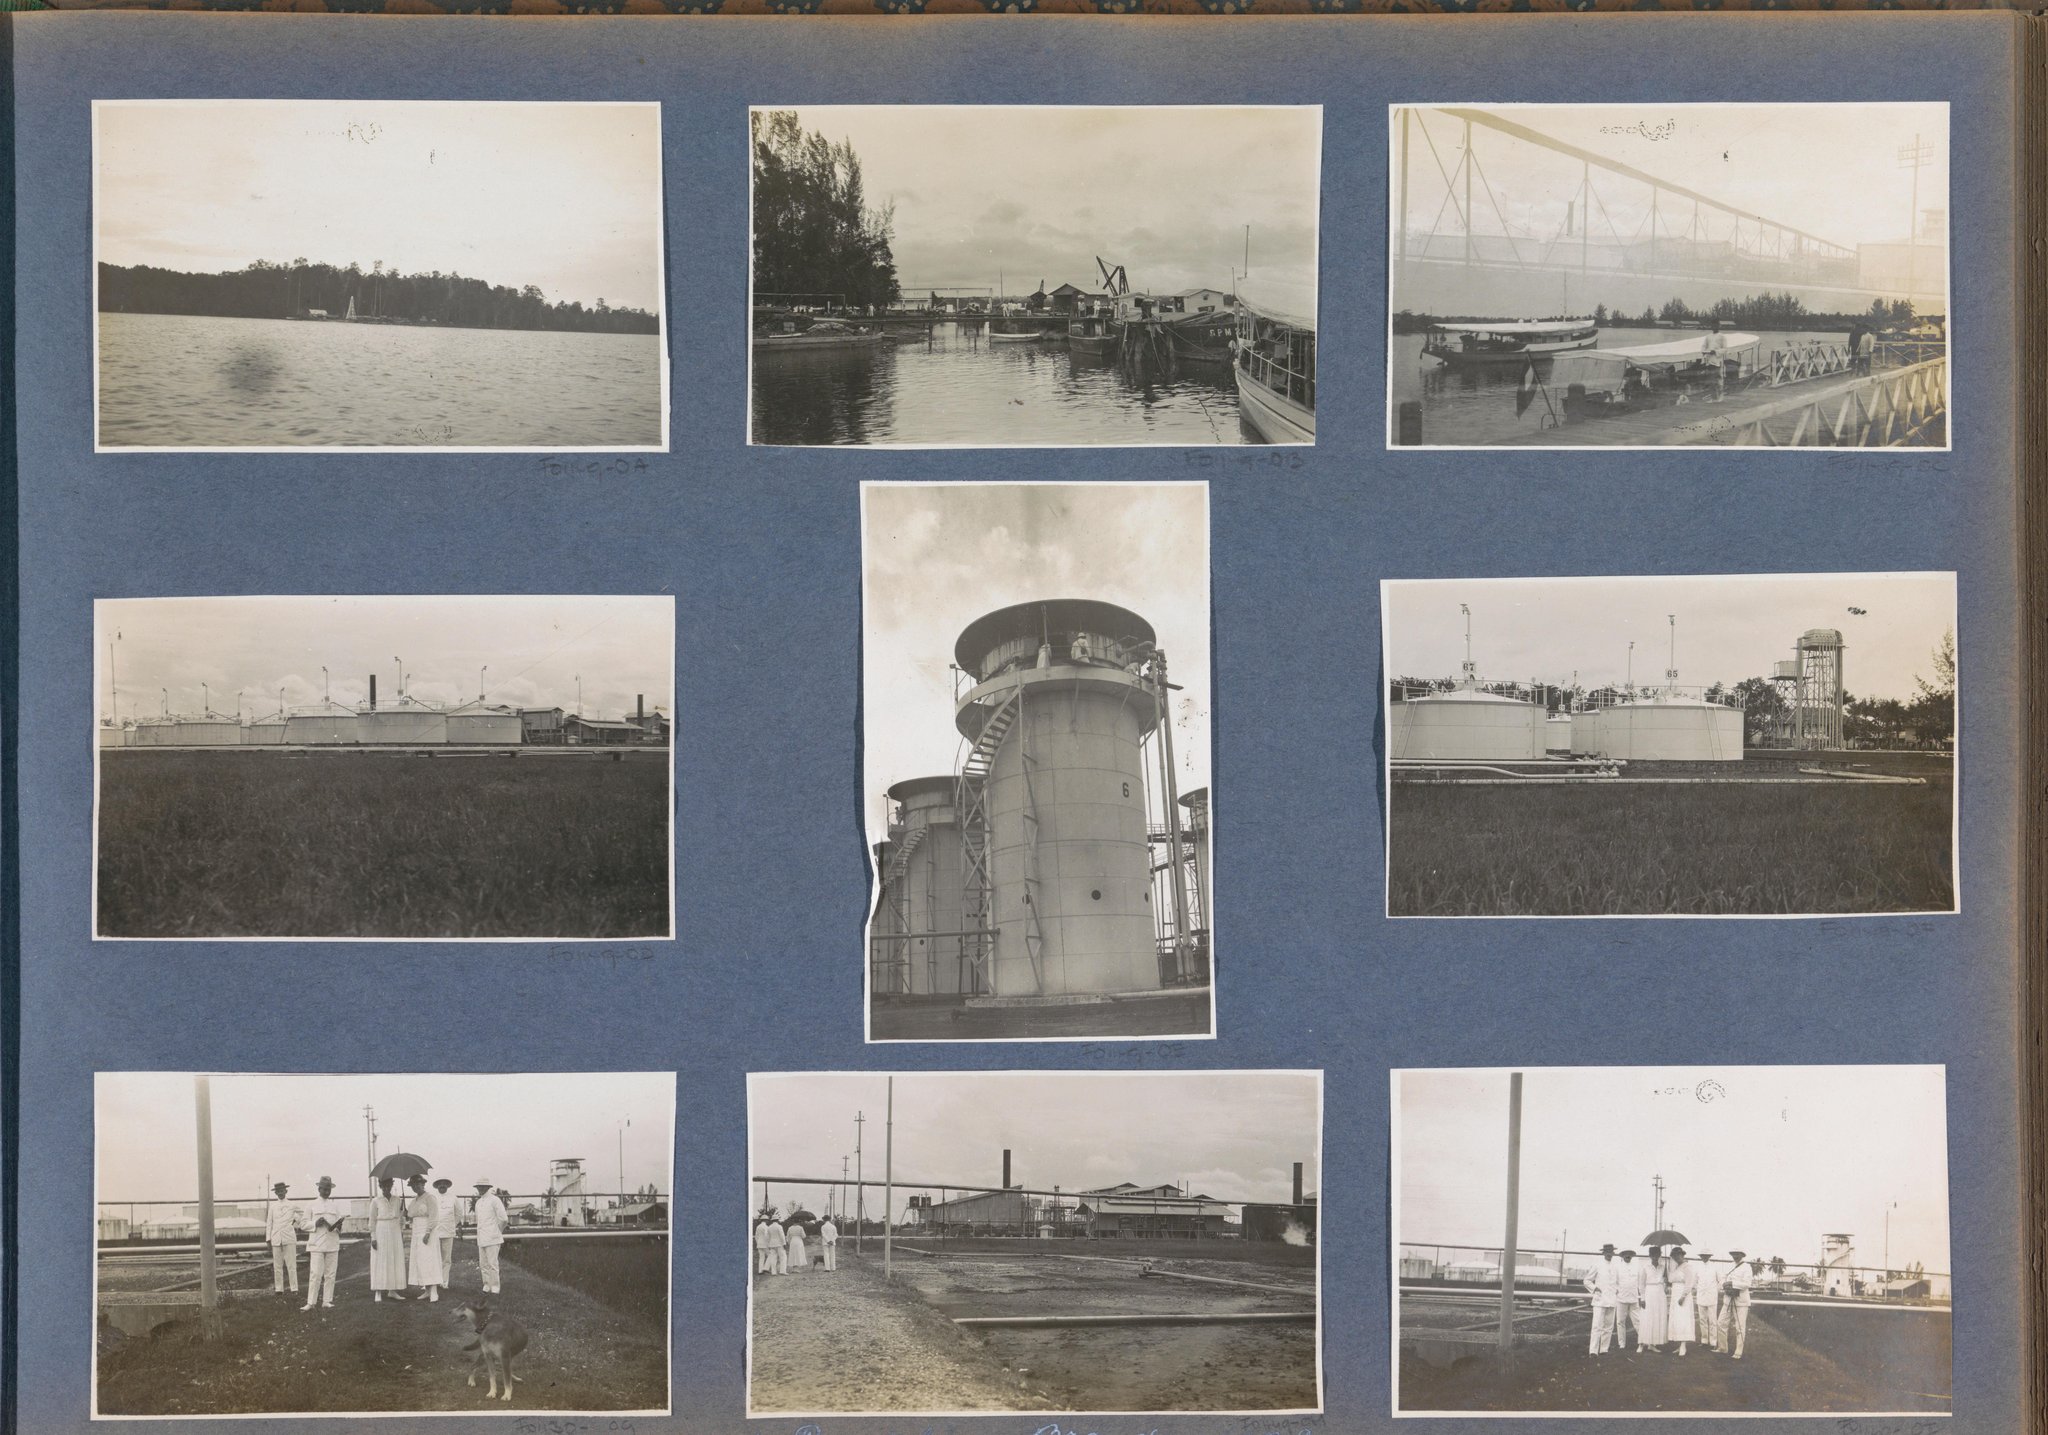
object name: album leaf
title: Groep mannen en vrouwen poserend bij een fabriekscomplex voor oliewinning te Pangkalan-Brandan op Sumatra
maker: Anonymous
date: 1900-1920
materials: paper, photographic support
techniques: gelatin silver print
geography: sumatra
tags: oil tanks, oil; oil refinery, dog, sumatra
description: Onderdeel van reisalbum met foto's van bedrijvigheid en bezienswaardigheden op Sumatra en Java en van de reis naar en van Nederlands-Indië.